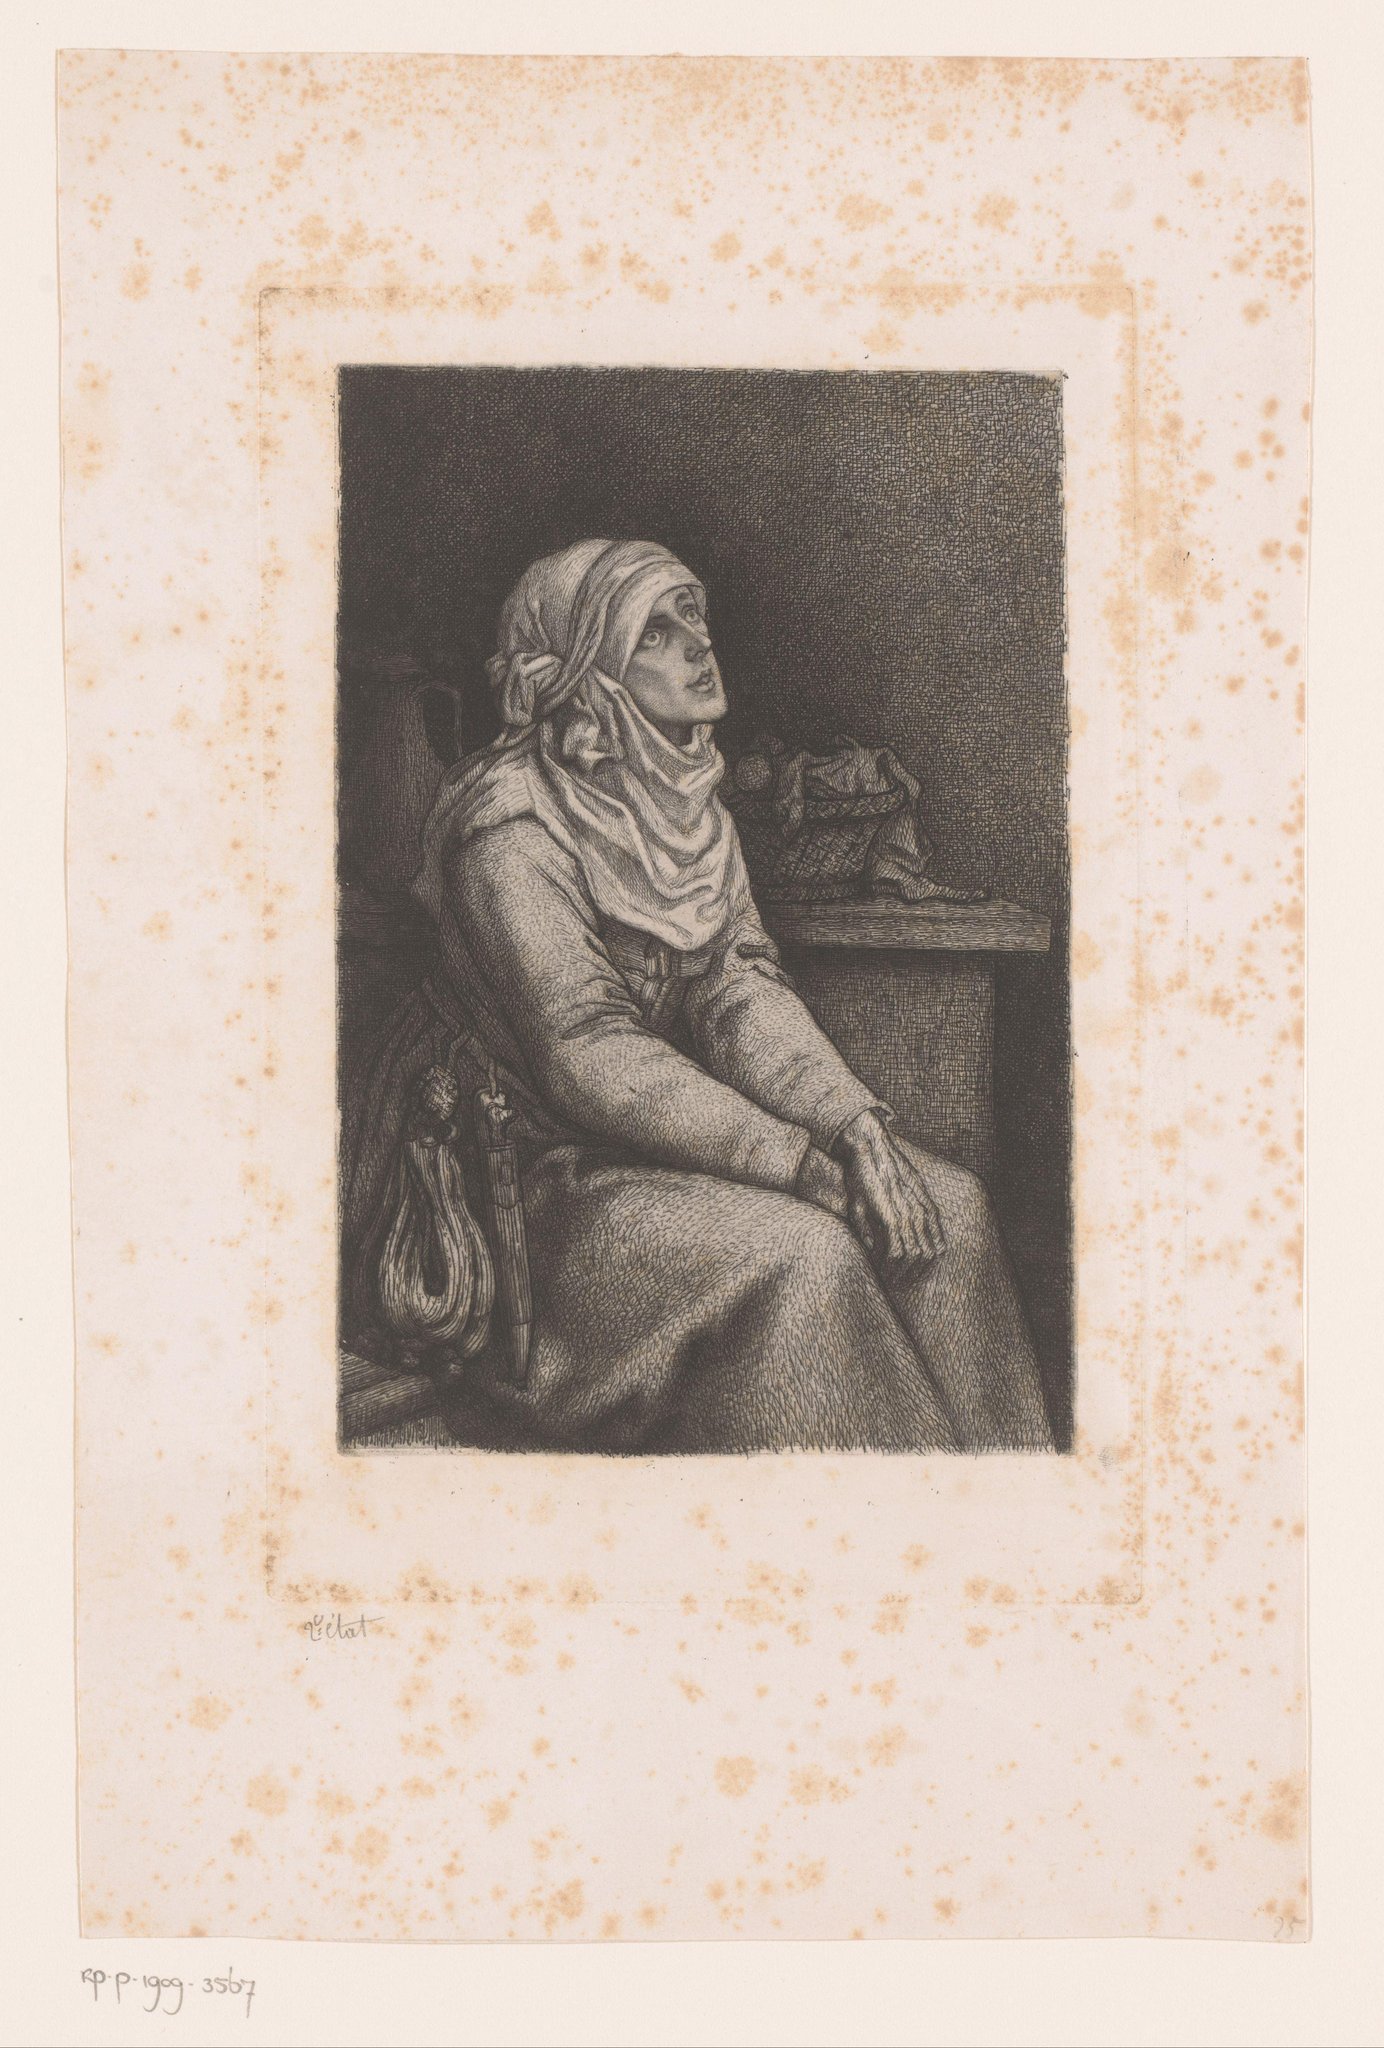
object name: print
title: Zittende vrouw kijkt schuin omhoog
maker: auguste danse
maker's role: print maker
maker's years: 1829-1929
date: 1864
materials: paper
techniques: drypoint, etching, intaglio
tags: adult woman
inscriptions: annotation: ‘2 état’, collector's mark: Lugt 2228